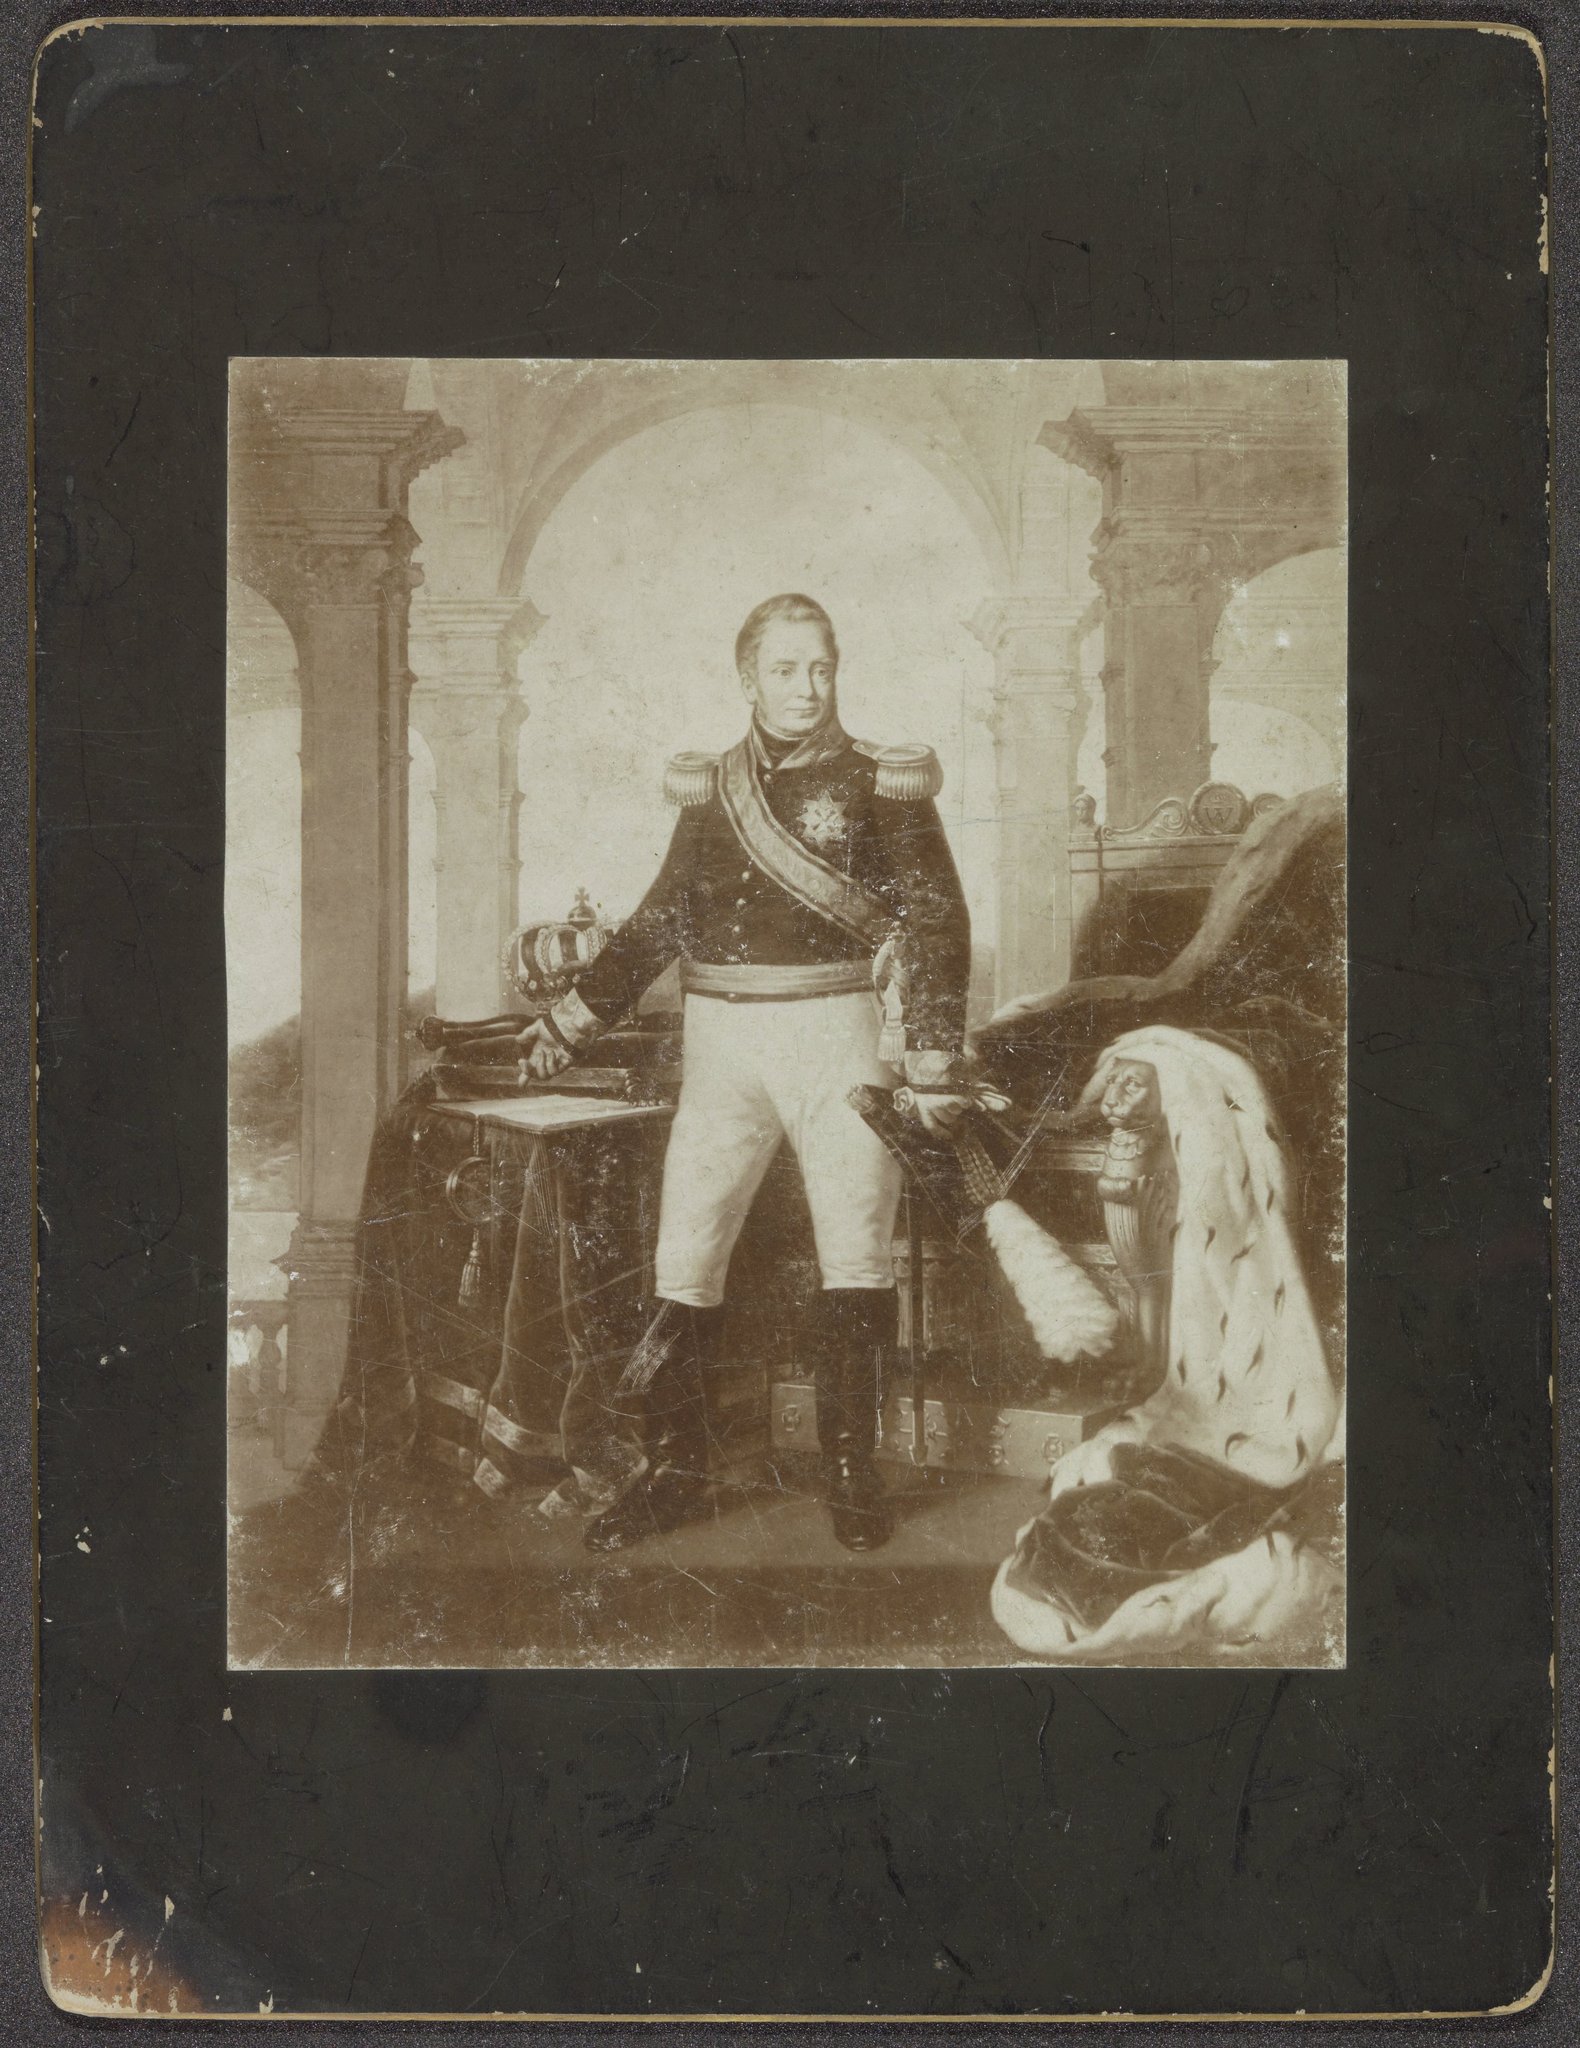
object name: photograph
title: portret van Koning Willem I naar schilderij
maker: m.m. couvée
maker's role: publisher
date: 1849-1920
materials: cardboard, photographic support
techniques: albumen print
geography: the hague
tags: the hague, berlin, william i of the netherlands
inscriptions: signature: ‘Libraire royale de M.M. Couvee lange Pooten 41 La Haye Photographies Tableaux Modernes Objets d'Art’